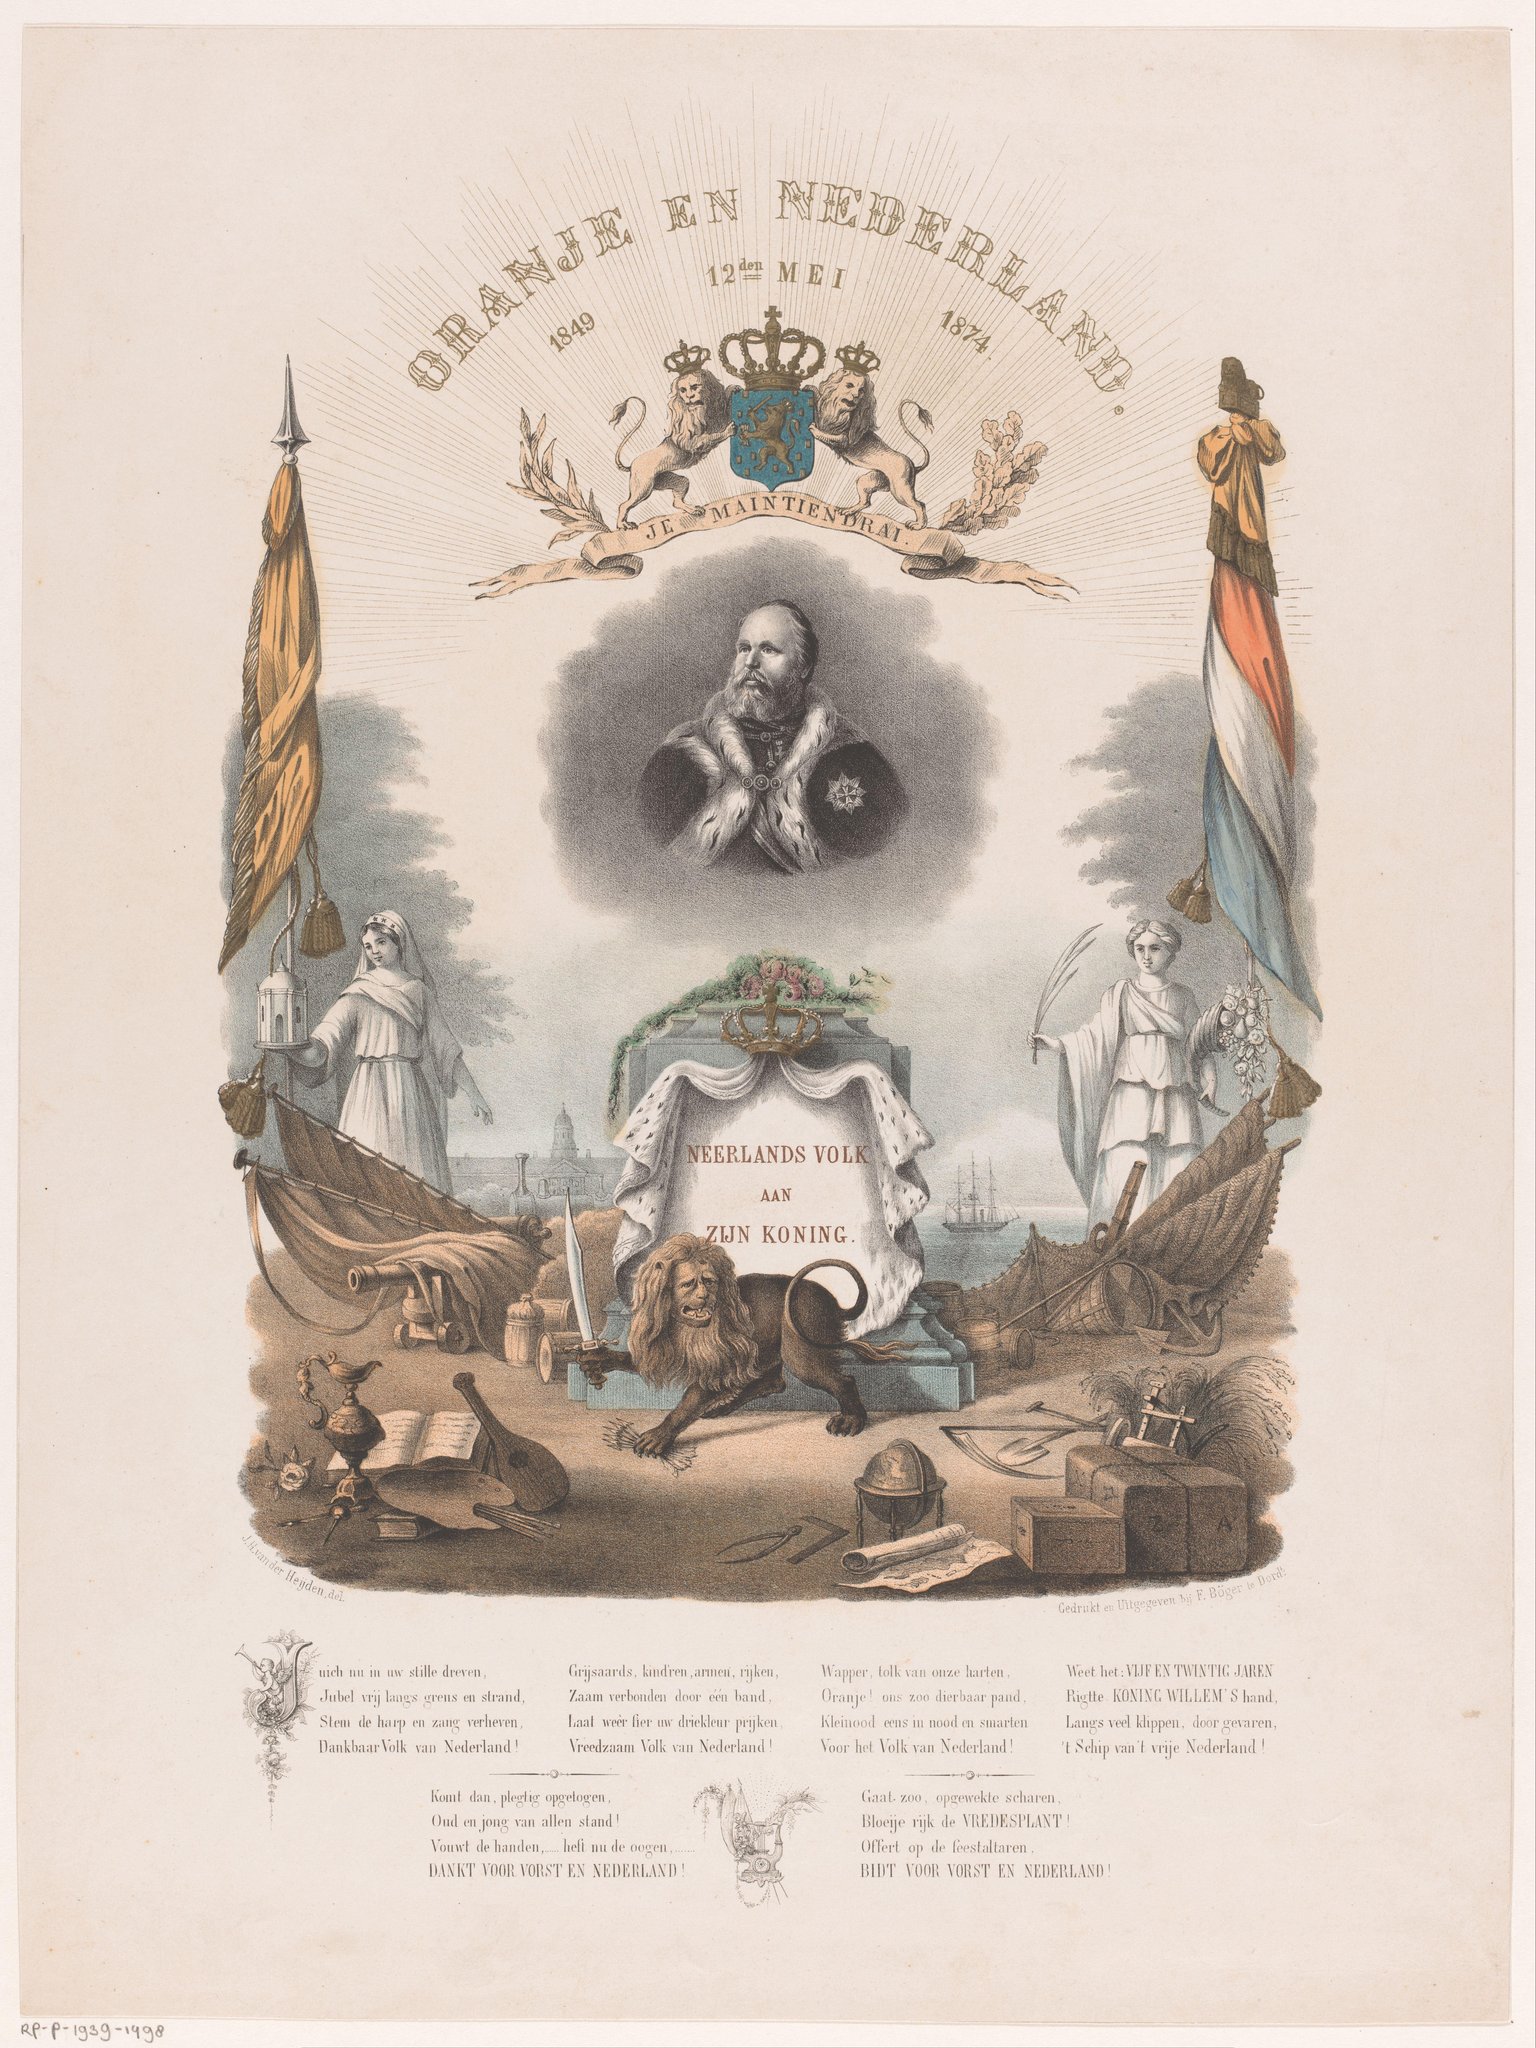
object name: print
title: Allegorie op het 25-jarige regeringsjubileum van Koning Willem III op 12 Mei 1874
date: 1846-1880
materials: paper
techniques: lithograph, hand coloring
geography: dordrecht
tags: brussels, willem iii (koning der nederlanden), beasts of prey, predatory animals: lion (+ animals used symbolically), national government, commemoration, jubilee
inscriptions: collector's mark: Lugt 2760, collector's mark: Lugt 2166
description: In het midden is Koning Willem III afgebeeld, geflankeerd door twee figuren met een oranje en Nederlandse vlag. Daaronder een monument met de kroon, hermelijnen mantel, een leeuw met zwaard en pijlen en diverse attributen die verwijzen naar oorlog, handel, wetenschap en voorspoed. Daaronder een gedicht.